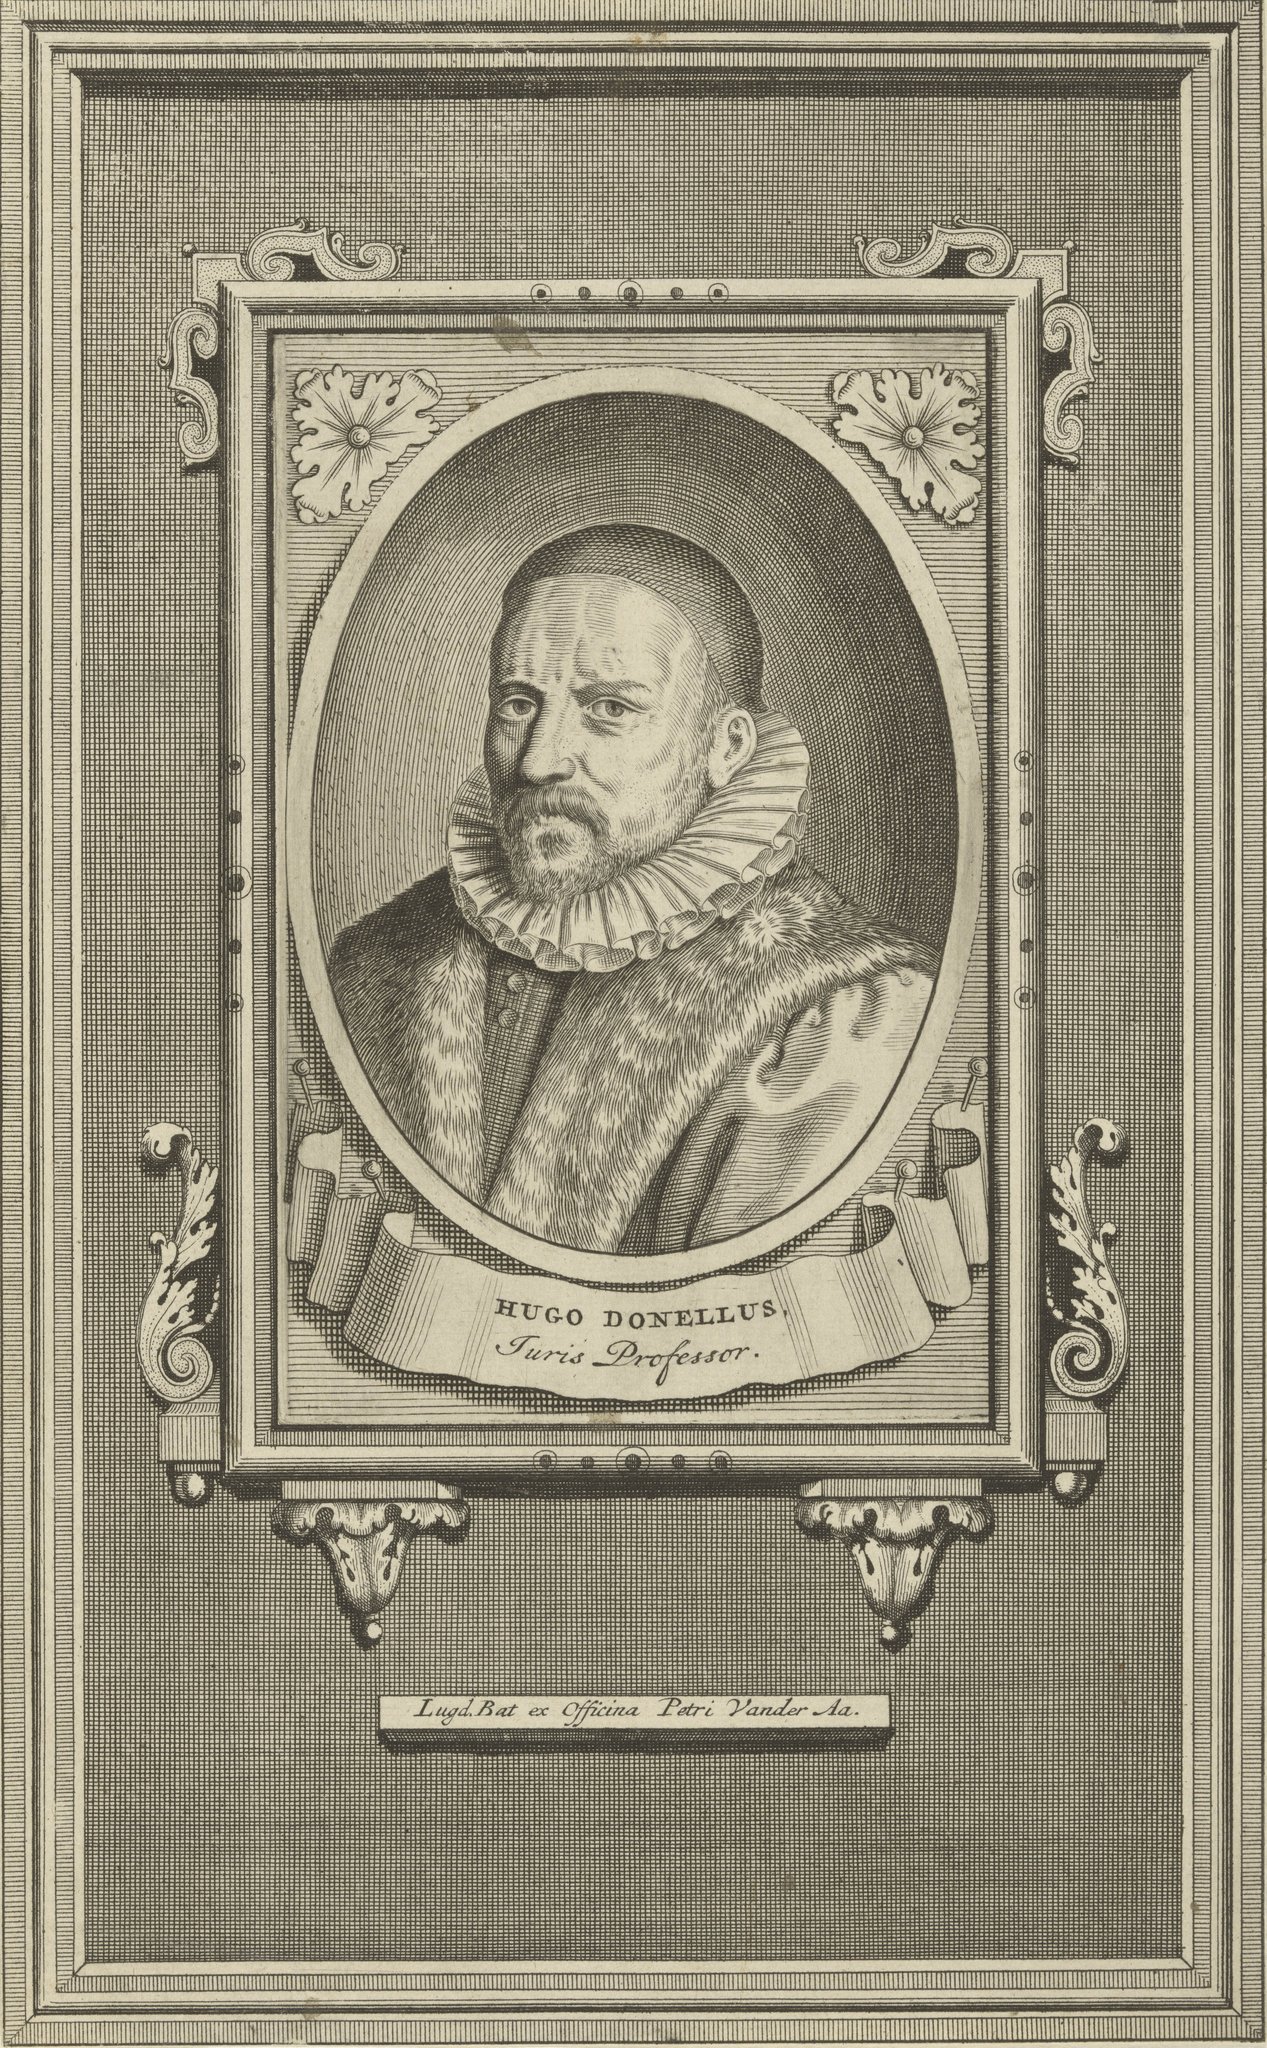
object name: book illustration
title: Portret van Hugo Donellus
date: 1609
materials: paper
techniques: engraving, etching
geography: leiden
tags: châlon-sur-saône, altdorf, rechtsgeleerde, professor, hugo donellus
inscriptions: collector's mark: Lugt 2228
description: Prent mogelijk gebruikt in: Fundatoris, curatorum et professorum (...) quorum gratiâ (...) Academia Lugduno-Batava incepit, auctaque & ornata est, effigies (...). = Le fondateur, les premiers curateurs (...) qui ont servi (...) l'illustre Academie de Leide. Leiden: Pieter van der Aa (I), [1714 of 1720?].